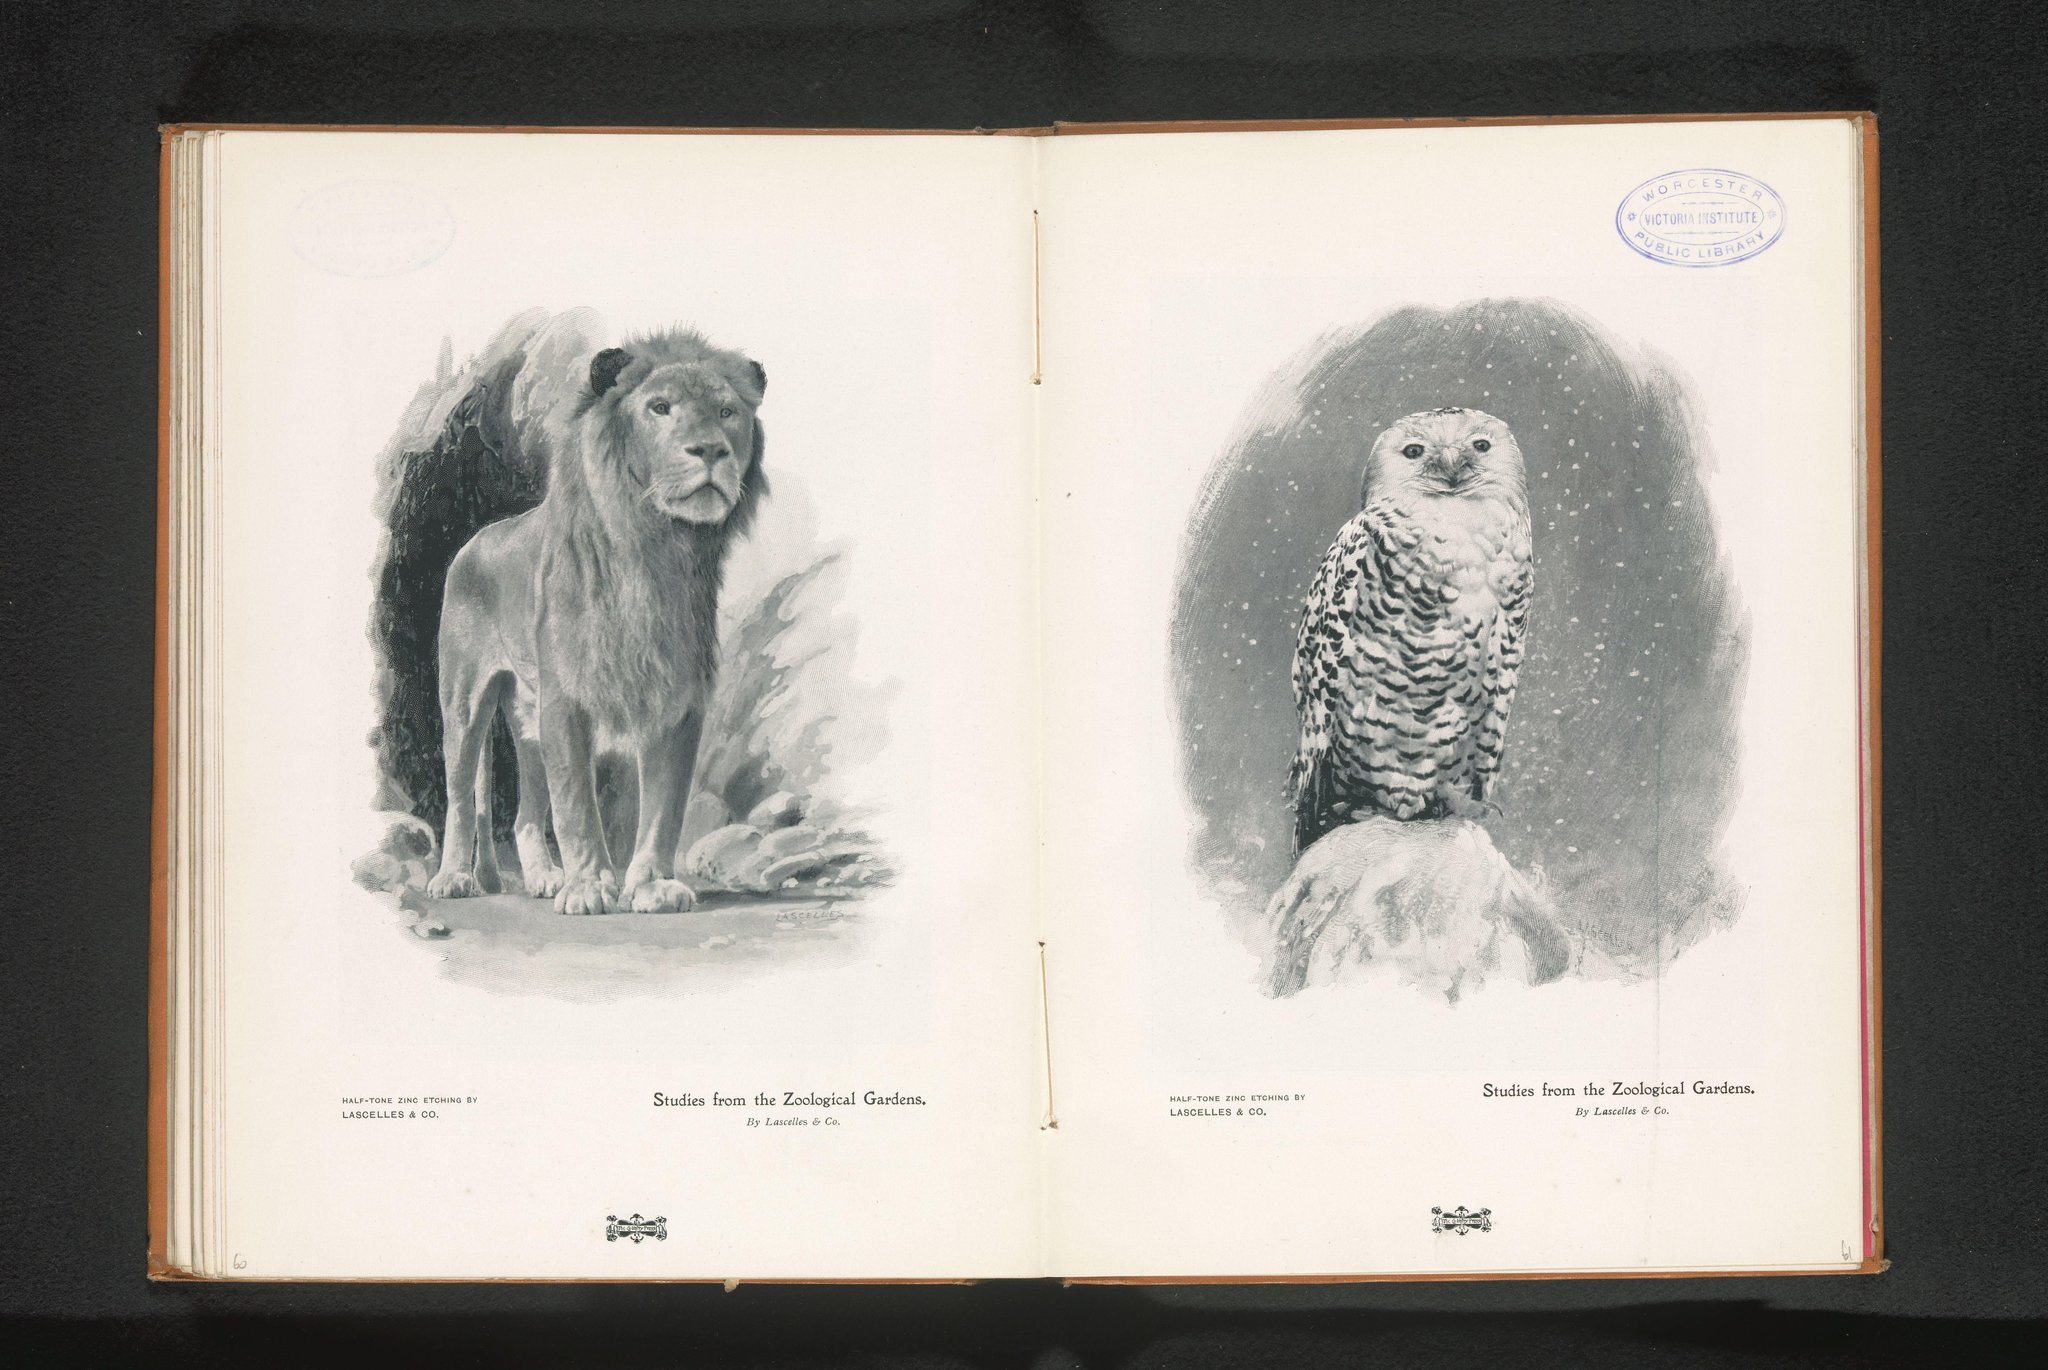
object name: photomechanical print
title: Sneeuwuil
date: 1894-1899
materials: paper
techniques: autotype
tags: owls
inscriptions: collector's mark: ‘Worcester Public Library/ Victoria Institute’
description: Prent op vijfde ongenummerde pagina na pagina 84.